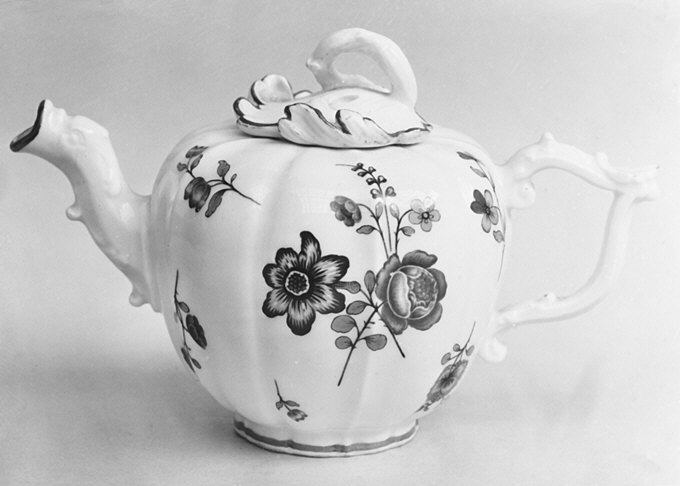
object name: teapot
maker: meissen manufactory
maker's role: manufactory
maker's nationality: german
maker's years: 1710-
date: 1701-1800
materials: hard paste porcelain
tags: flowers